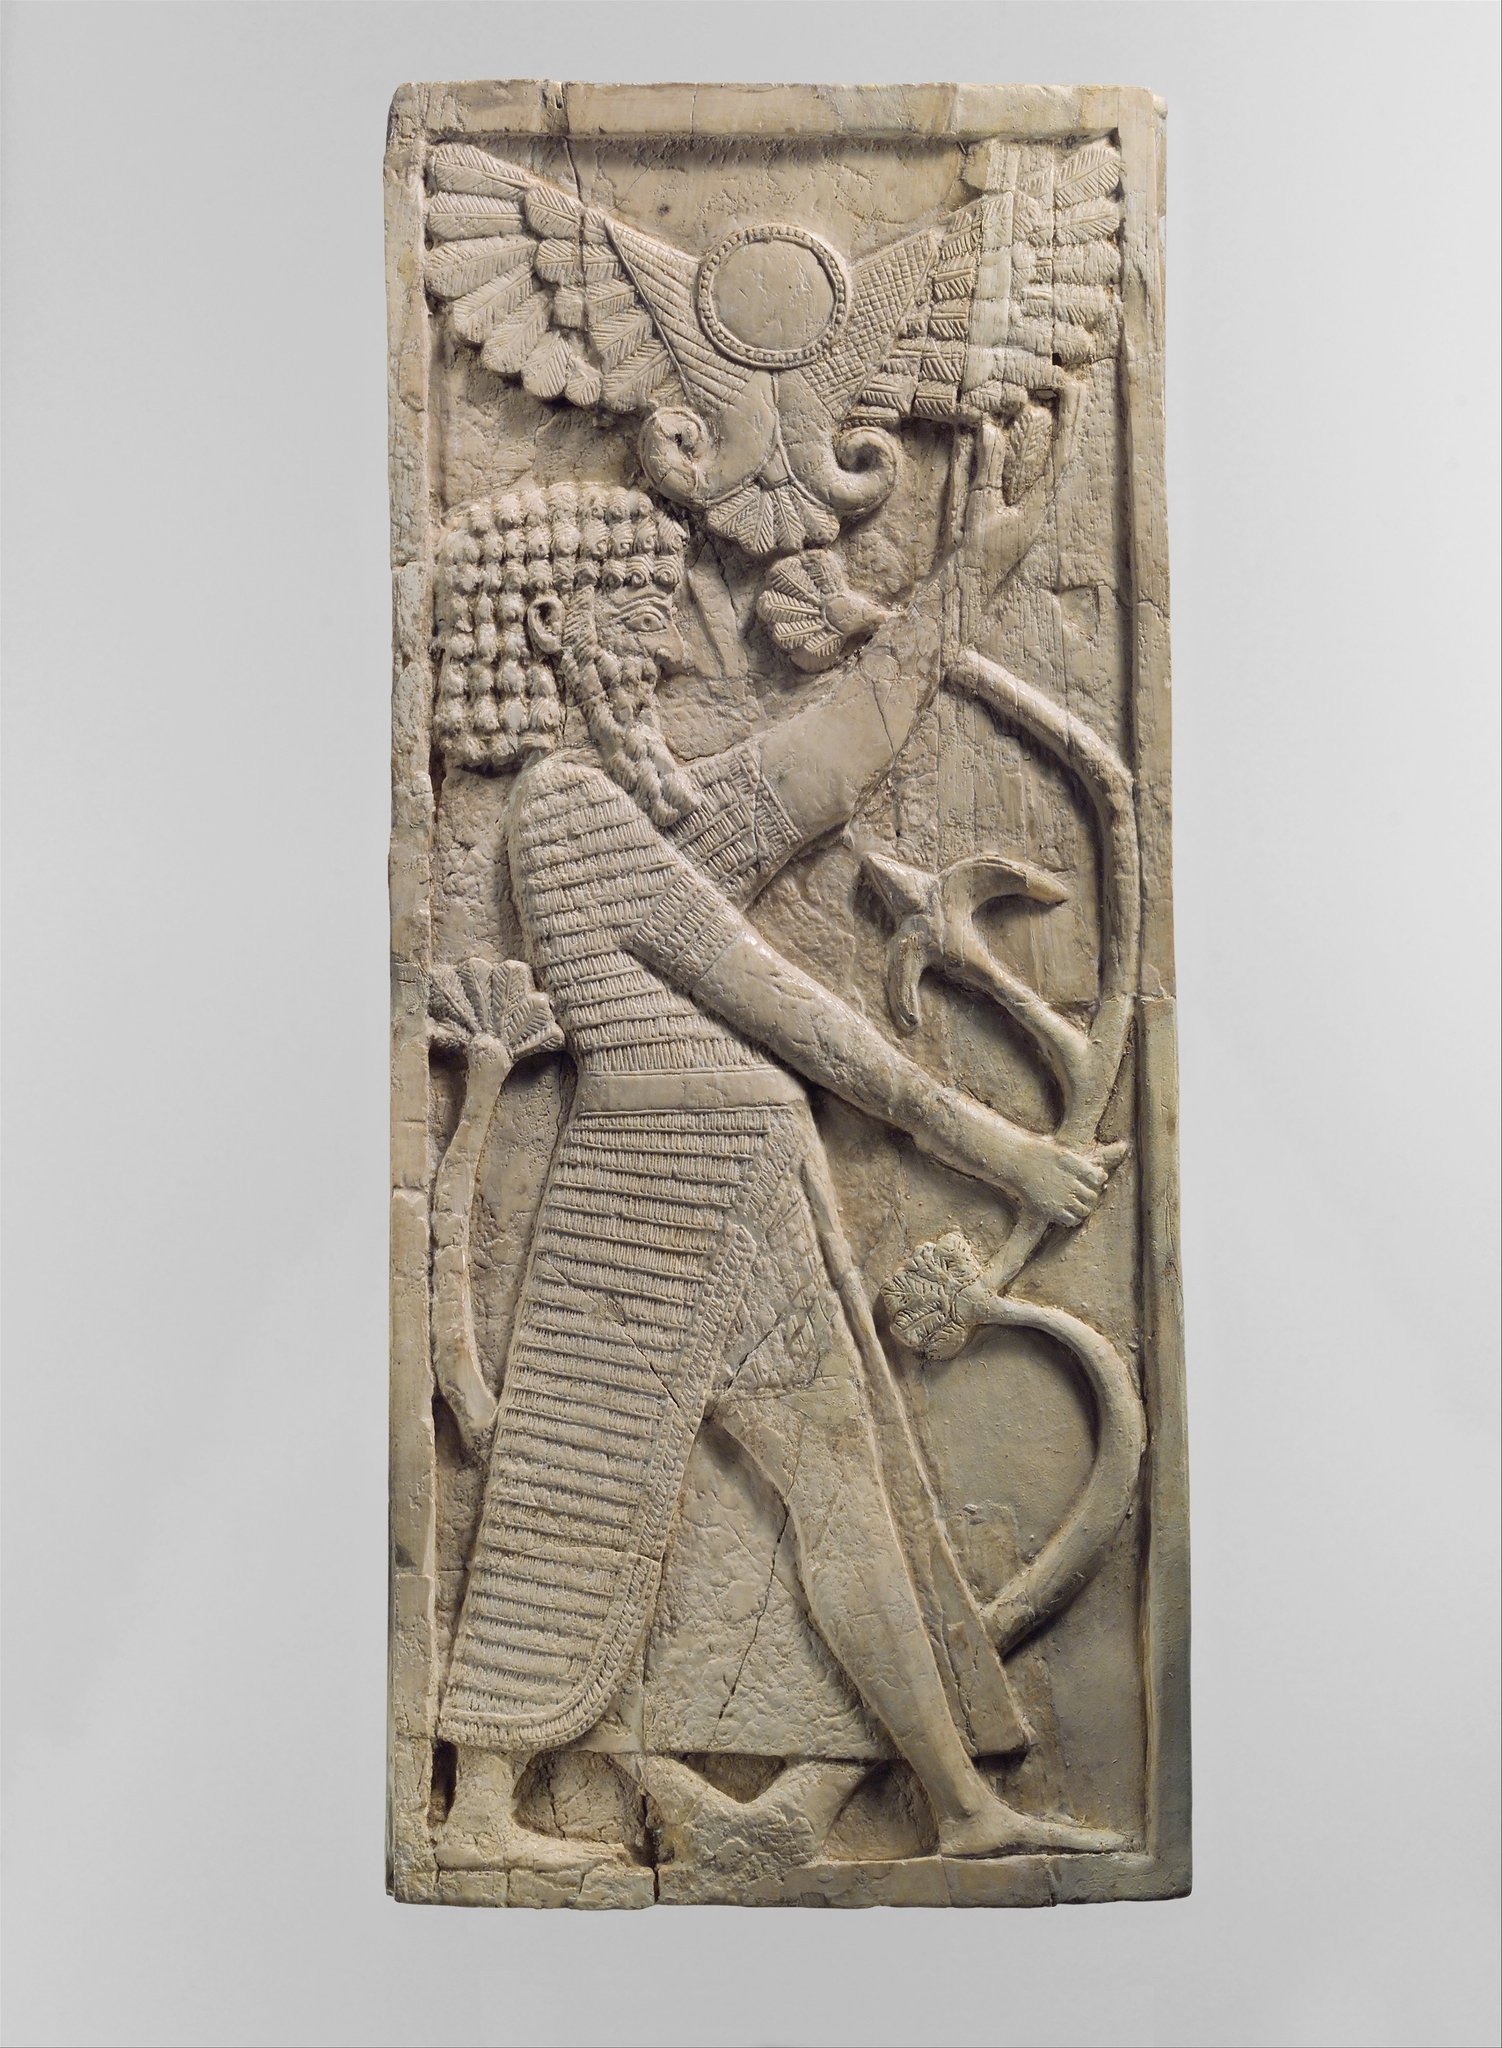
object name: relief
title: Furniture plaque carved in relief with a male figure grasping a tree; winged sun disc above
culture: assyrian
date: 800-701 BCE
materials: ivory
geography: mesopotamia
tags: men,trees